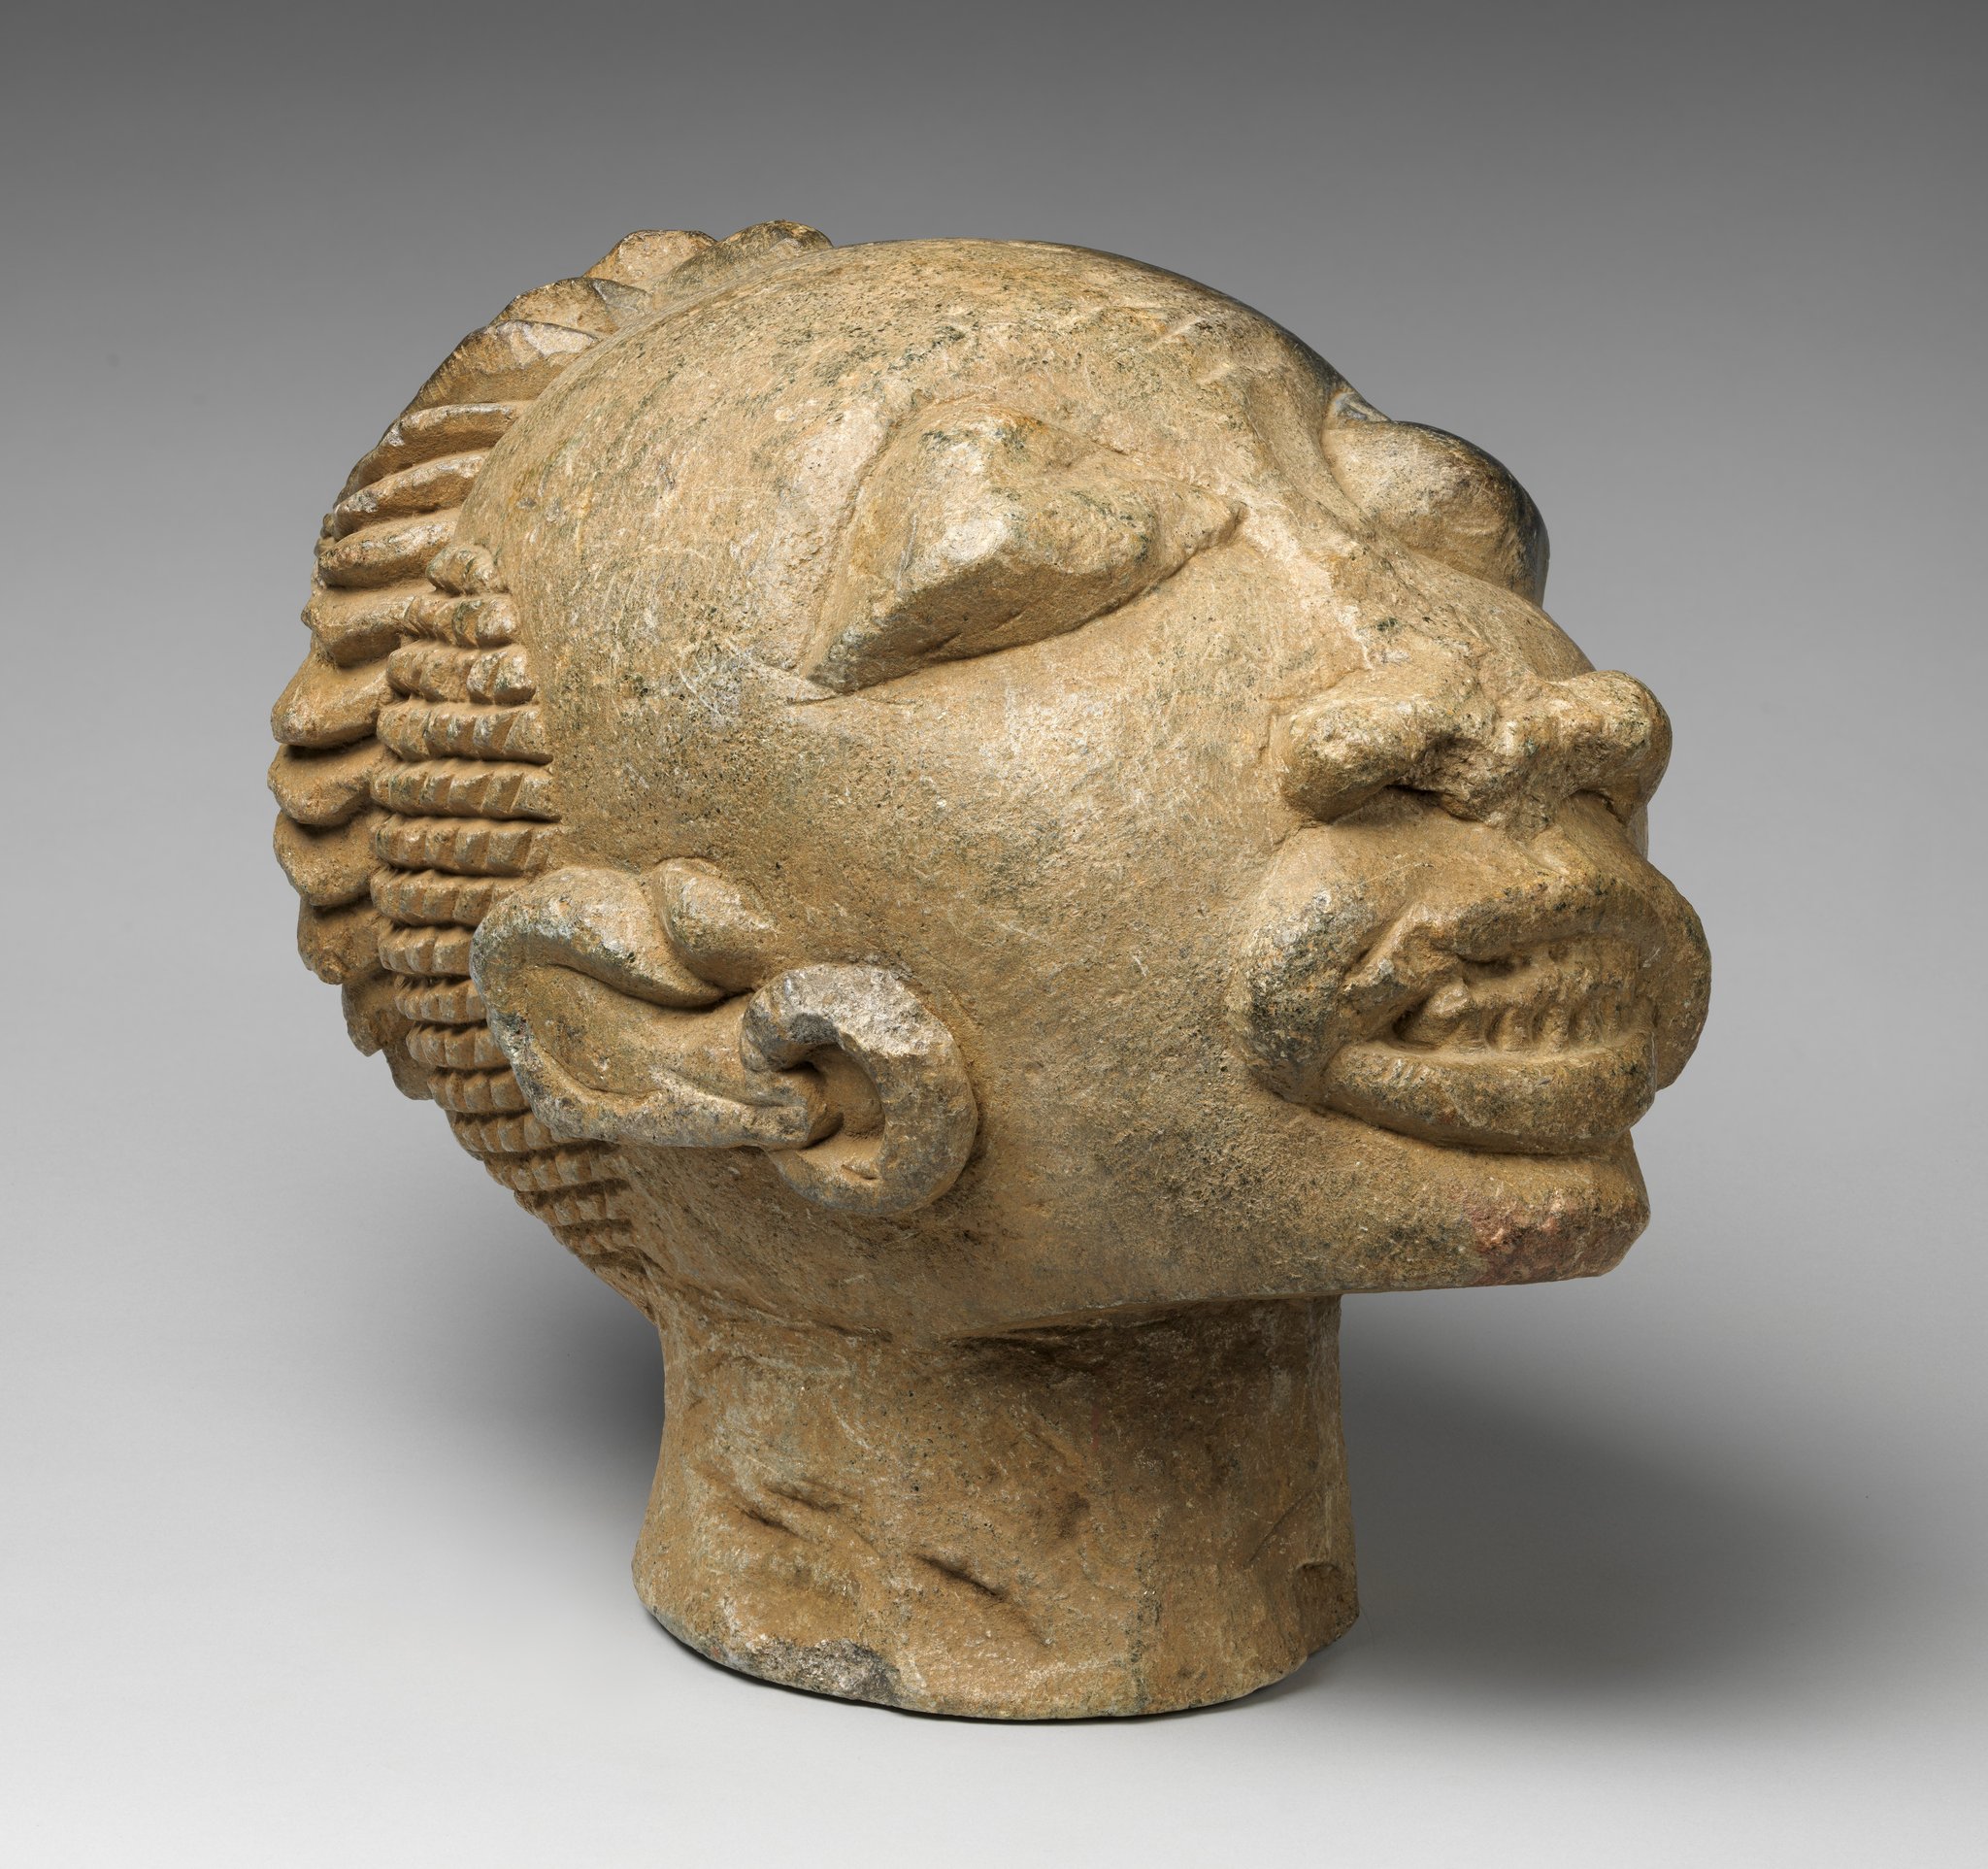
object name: head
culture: bullom or temne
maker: temne or bullom artist(s)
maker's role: artist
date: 1101-1600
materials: stone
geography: sierra leone